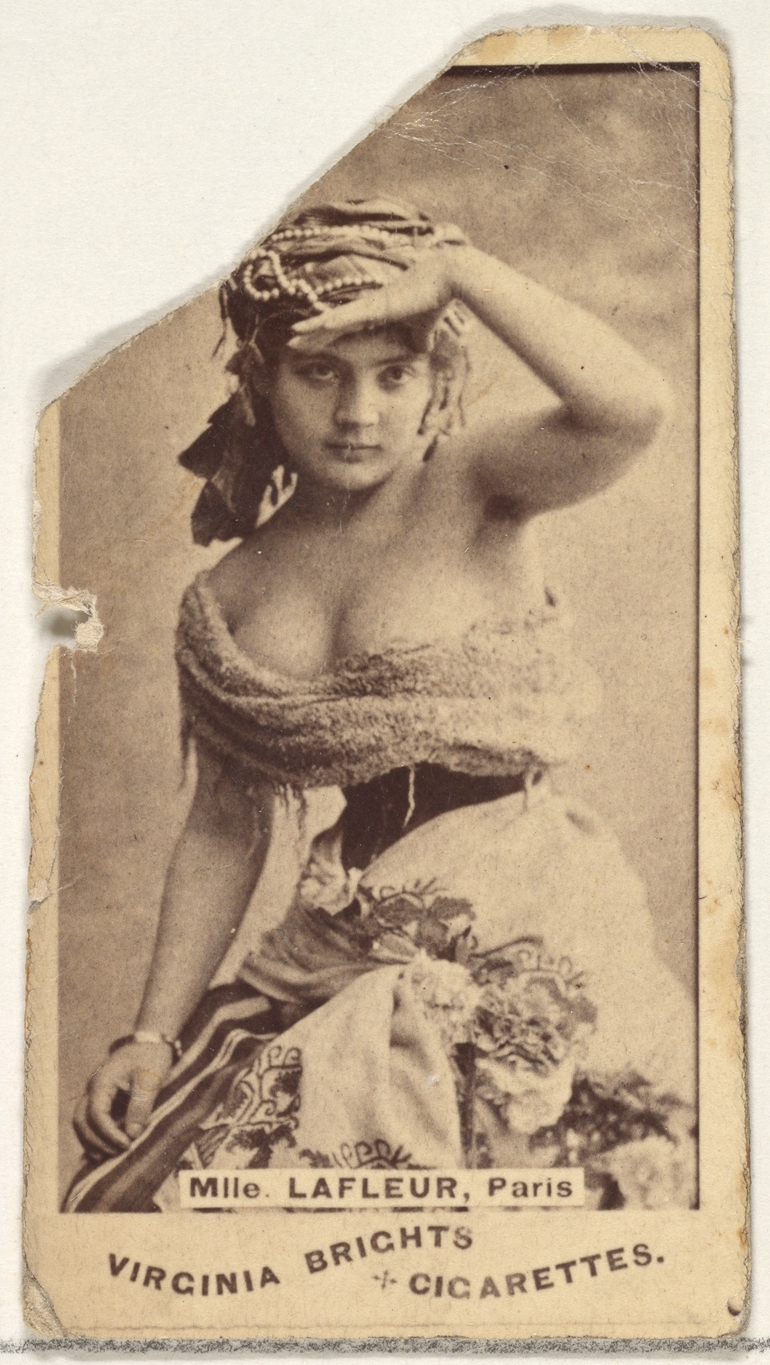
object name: photograph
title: Mlle. Lafleur, Paris, from the Actors and Actresses series (N45, Type 1) for Virginia Brights Cigarettes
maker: allen & ginter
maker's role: publisher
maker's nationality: american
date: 1888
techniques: albumen silver print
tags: portraits,women,actresses